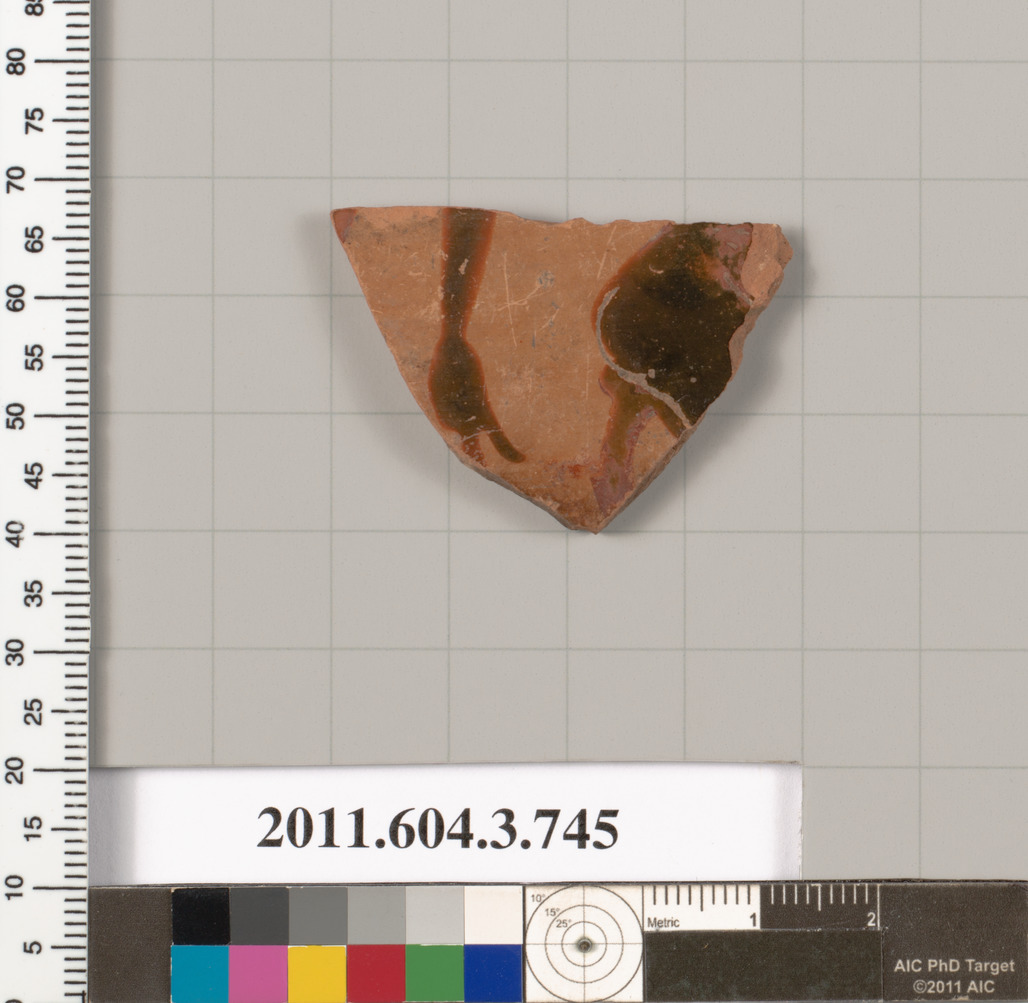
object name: neck amphora, tyrrhenian fragment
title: Terracotta fragment of a neck-amphora (jar)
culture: greek, attic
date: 575-551 BCE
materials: terracotta